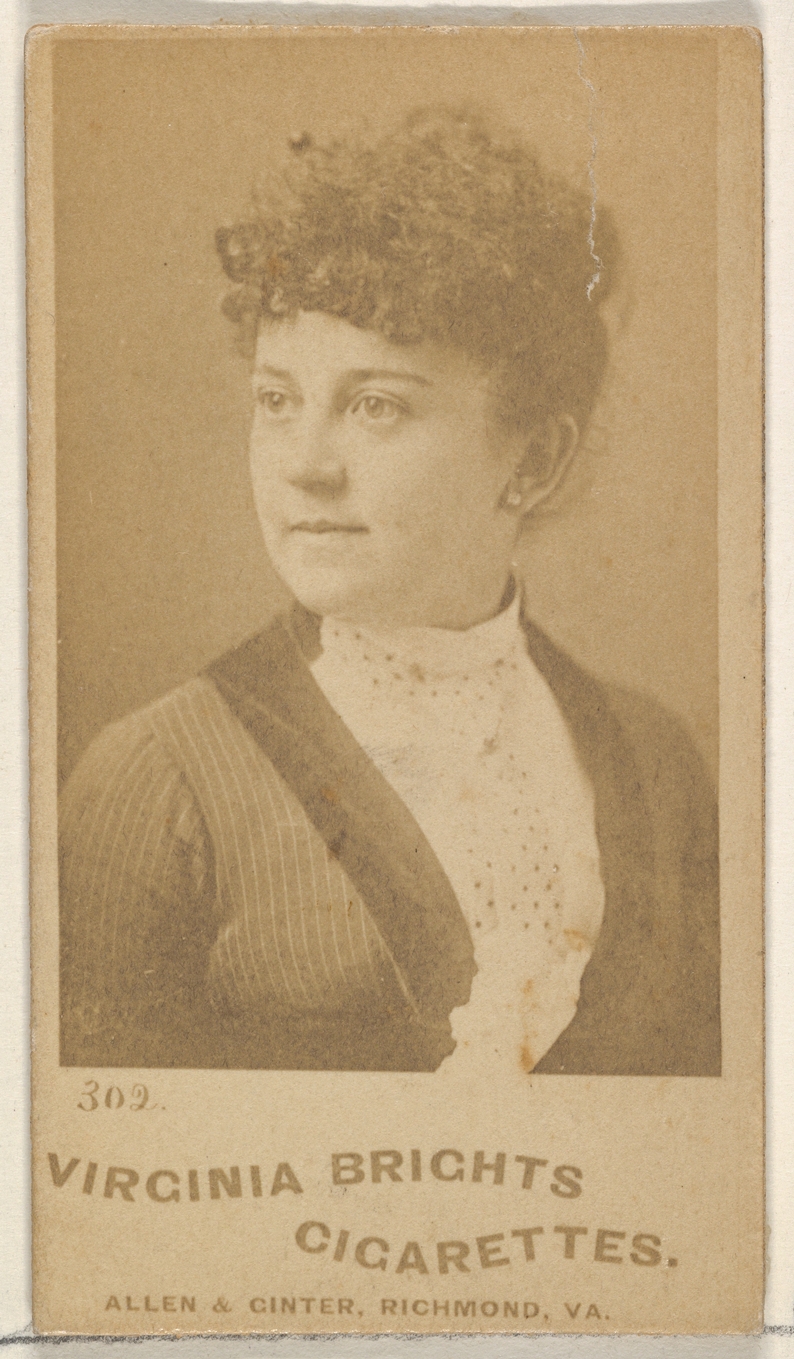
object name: photograph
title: Card 302, from the Actors and Actresses series (N45, Type 5) for Virginia Brights Cigarettes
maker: allen & ginter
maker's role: publisher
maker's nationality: american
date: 1888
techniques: albumen silver print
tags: portraits,women,actresses